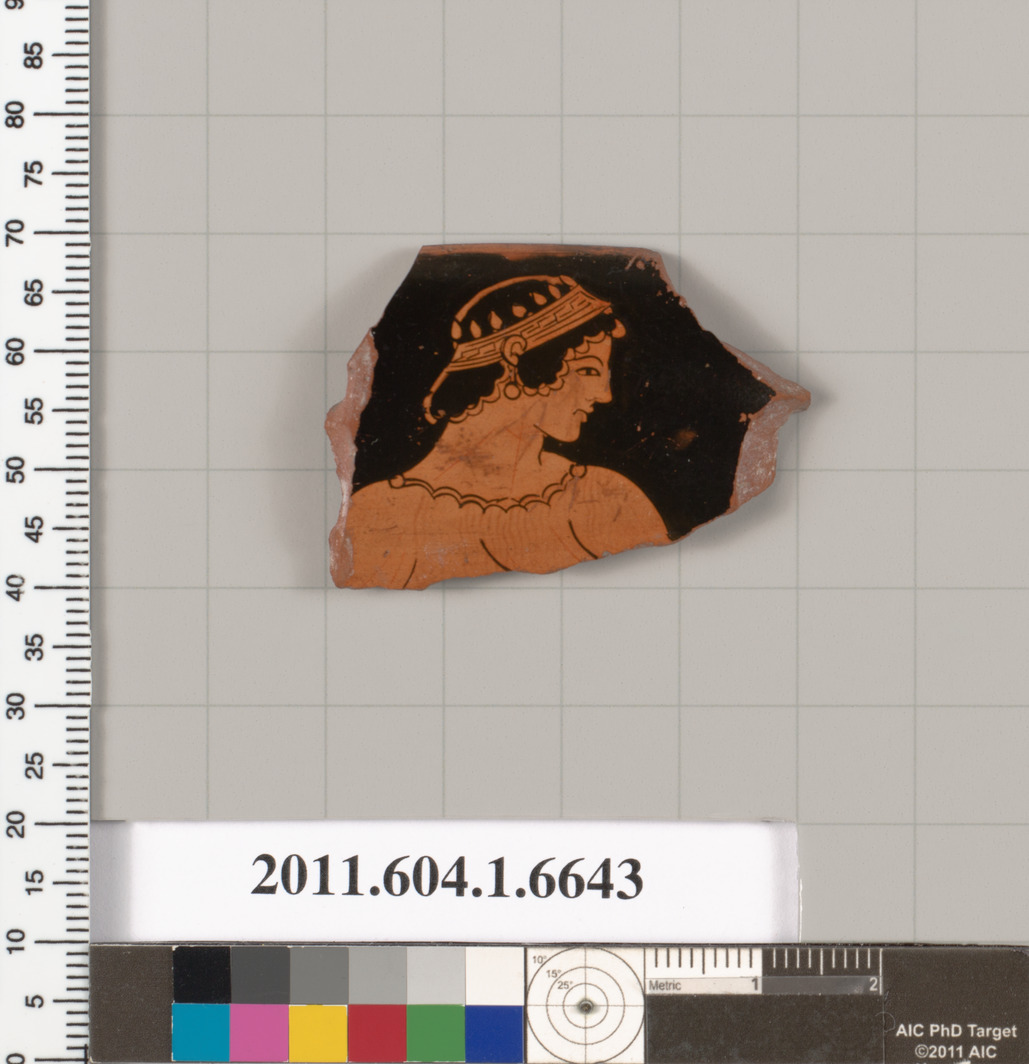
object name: kylix fragment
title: Terracotta rim fragment of a kylix (drinking cup)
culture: greek, attic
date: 490-470 BCE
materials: terracotta